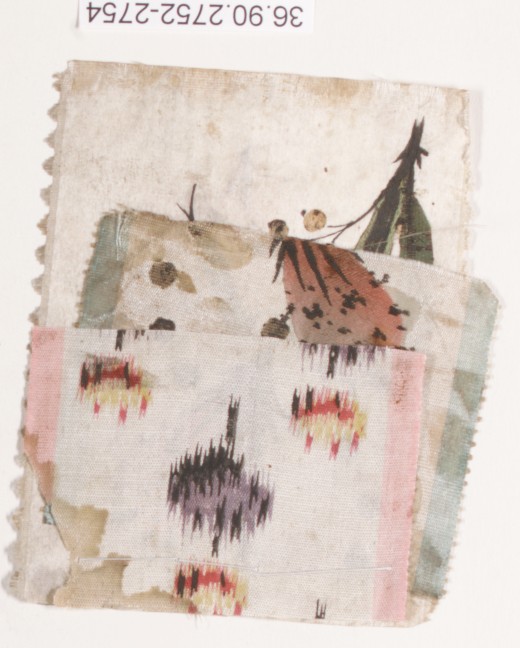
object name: ribbon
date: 1801-1900